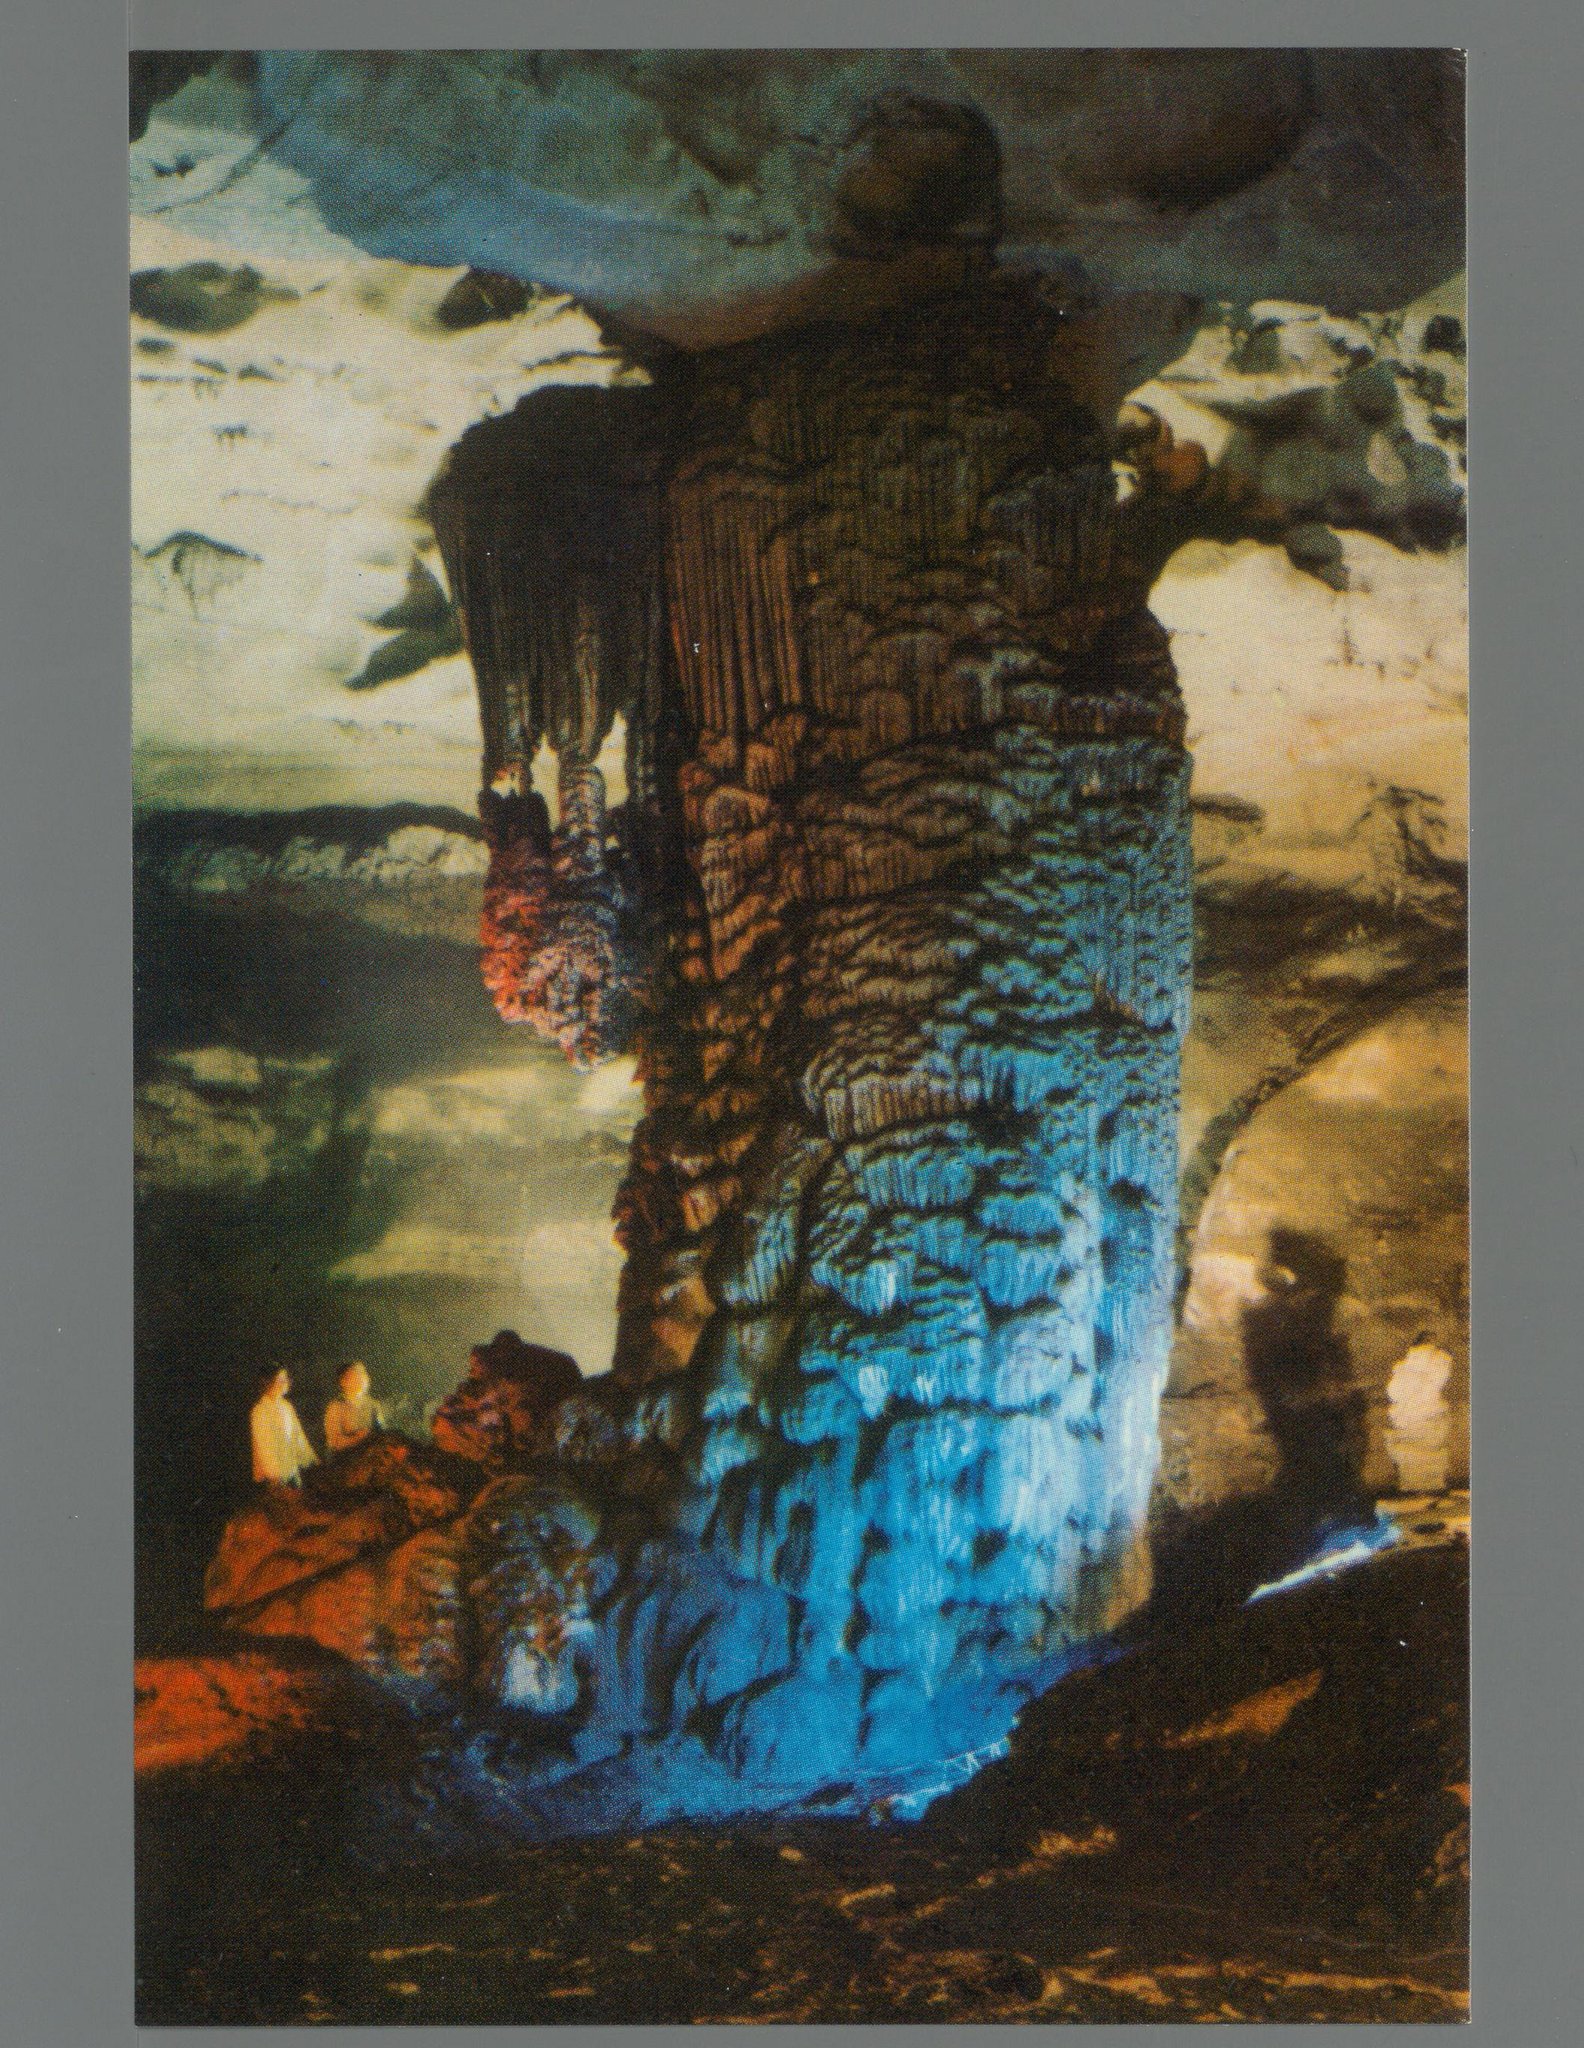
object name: ansichtkaart, prentbriefkaart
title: Dripstones in Seven Star Cavern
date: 1974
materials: cardboard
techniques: offset printed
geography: beijing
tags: stalactitic cave